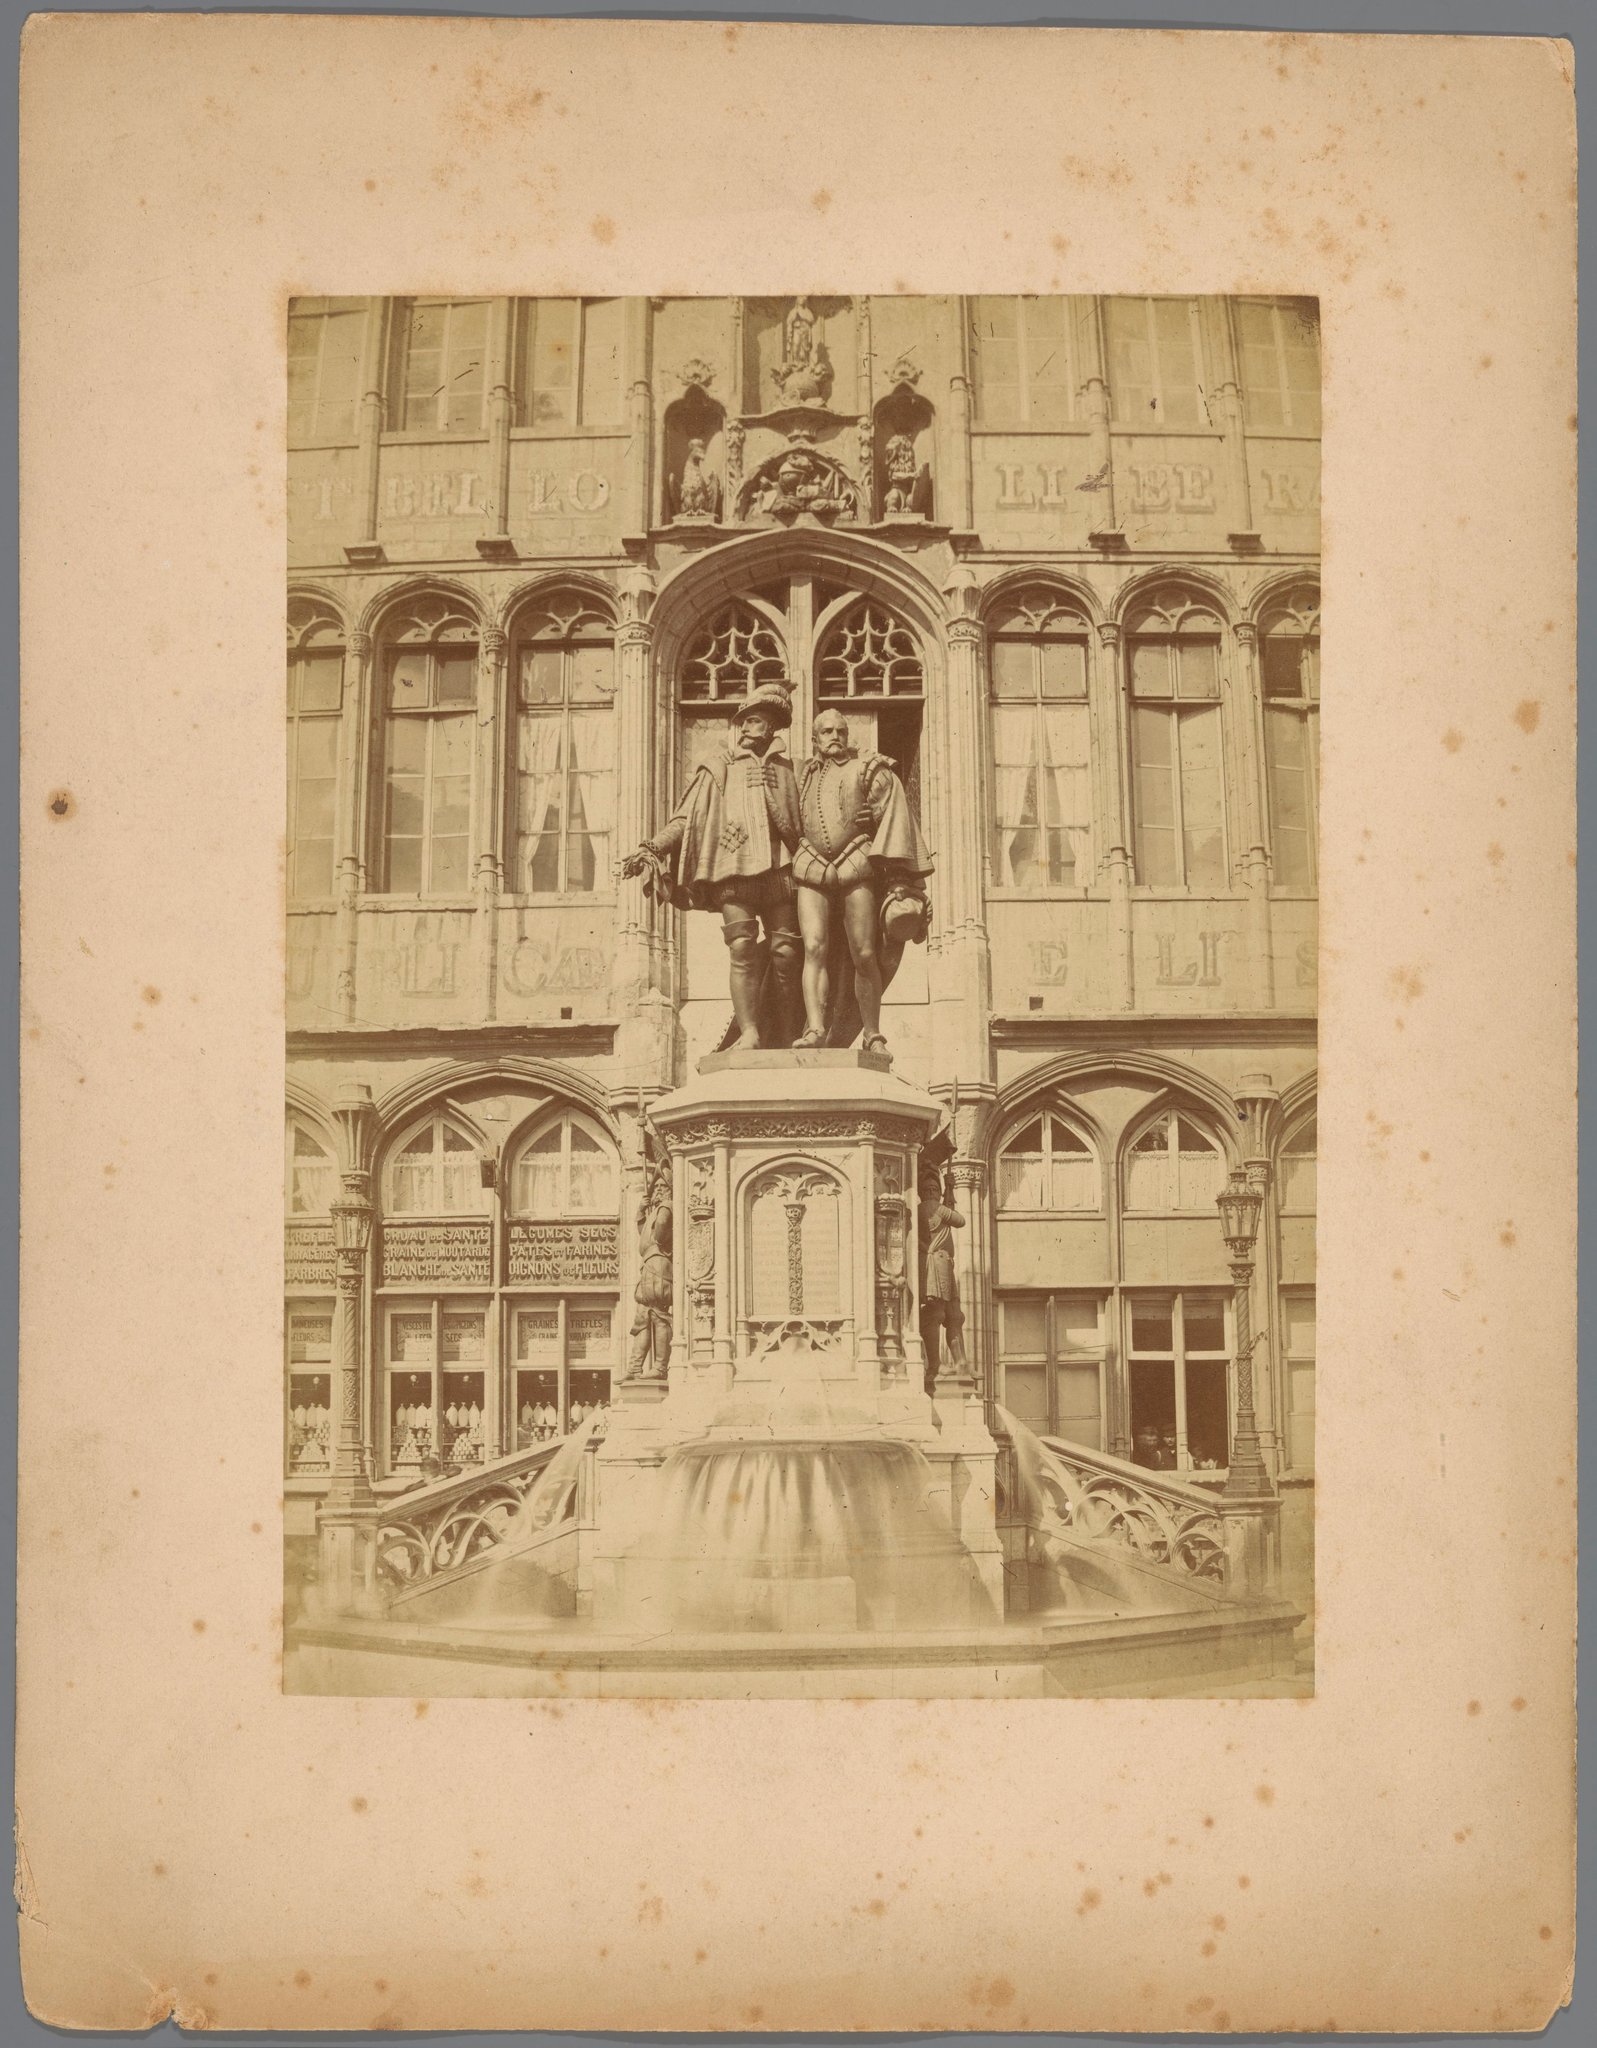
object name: photograph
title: Fontein met beelden van de graven van Egmont en Hoorn te Brussel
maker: Anonymous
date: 1875-1900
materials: cardboard, photographic support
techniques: albumen print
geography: brussels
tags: monument, statue, parts of church exterior and annexes: façade, ornamental fountain, brussels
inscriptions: name: ‘L. DREYFUS MICHEL ANVERS Marché aux Souliers, 3’, inscription: ‘Bruxelles Statues Comtes Egmont et Hoorn’